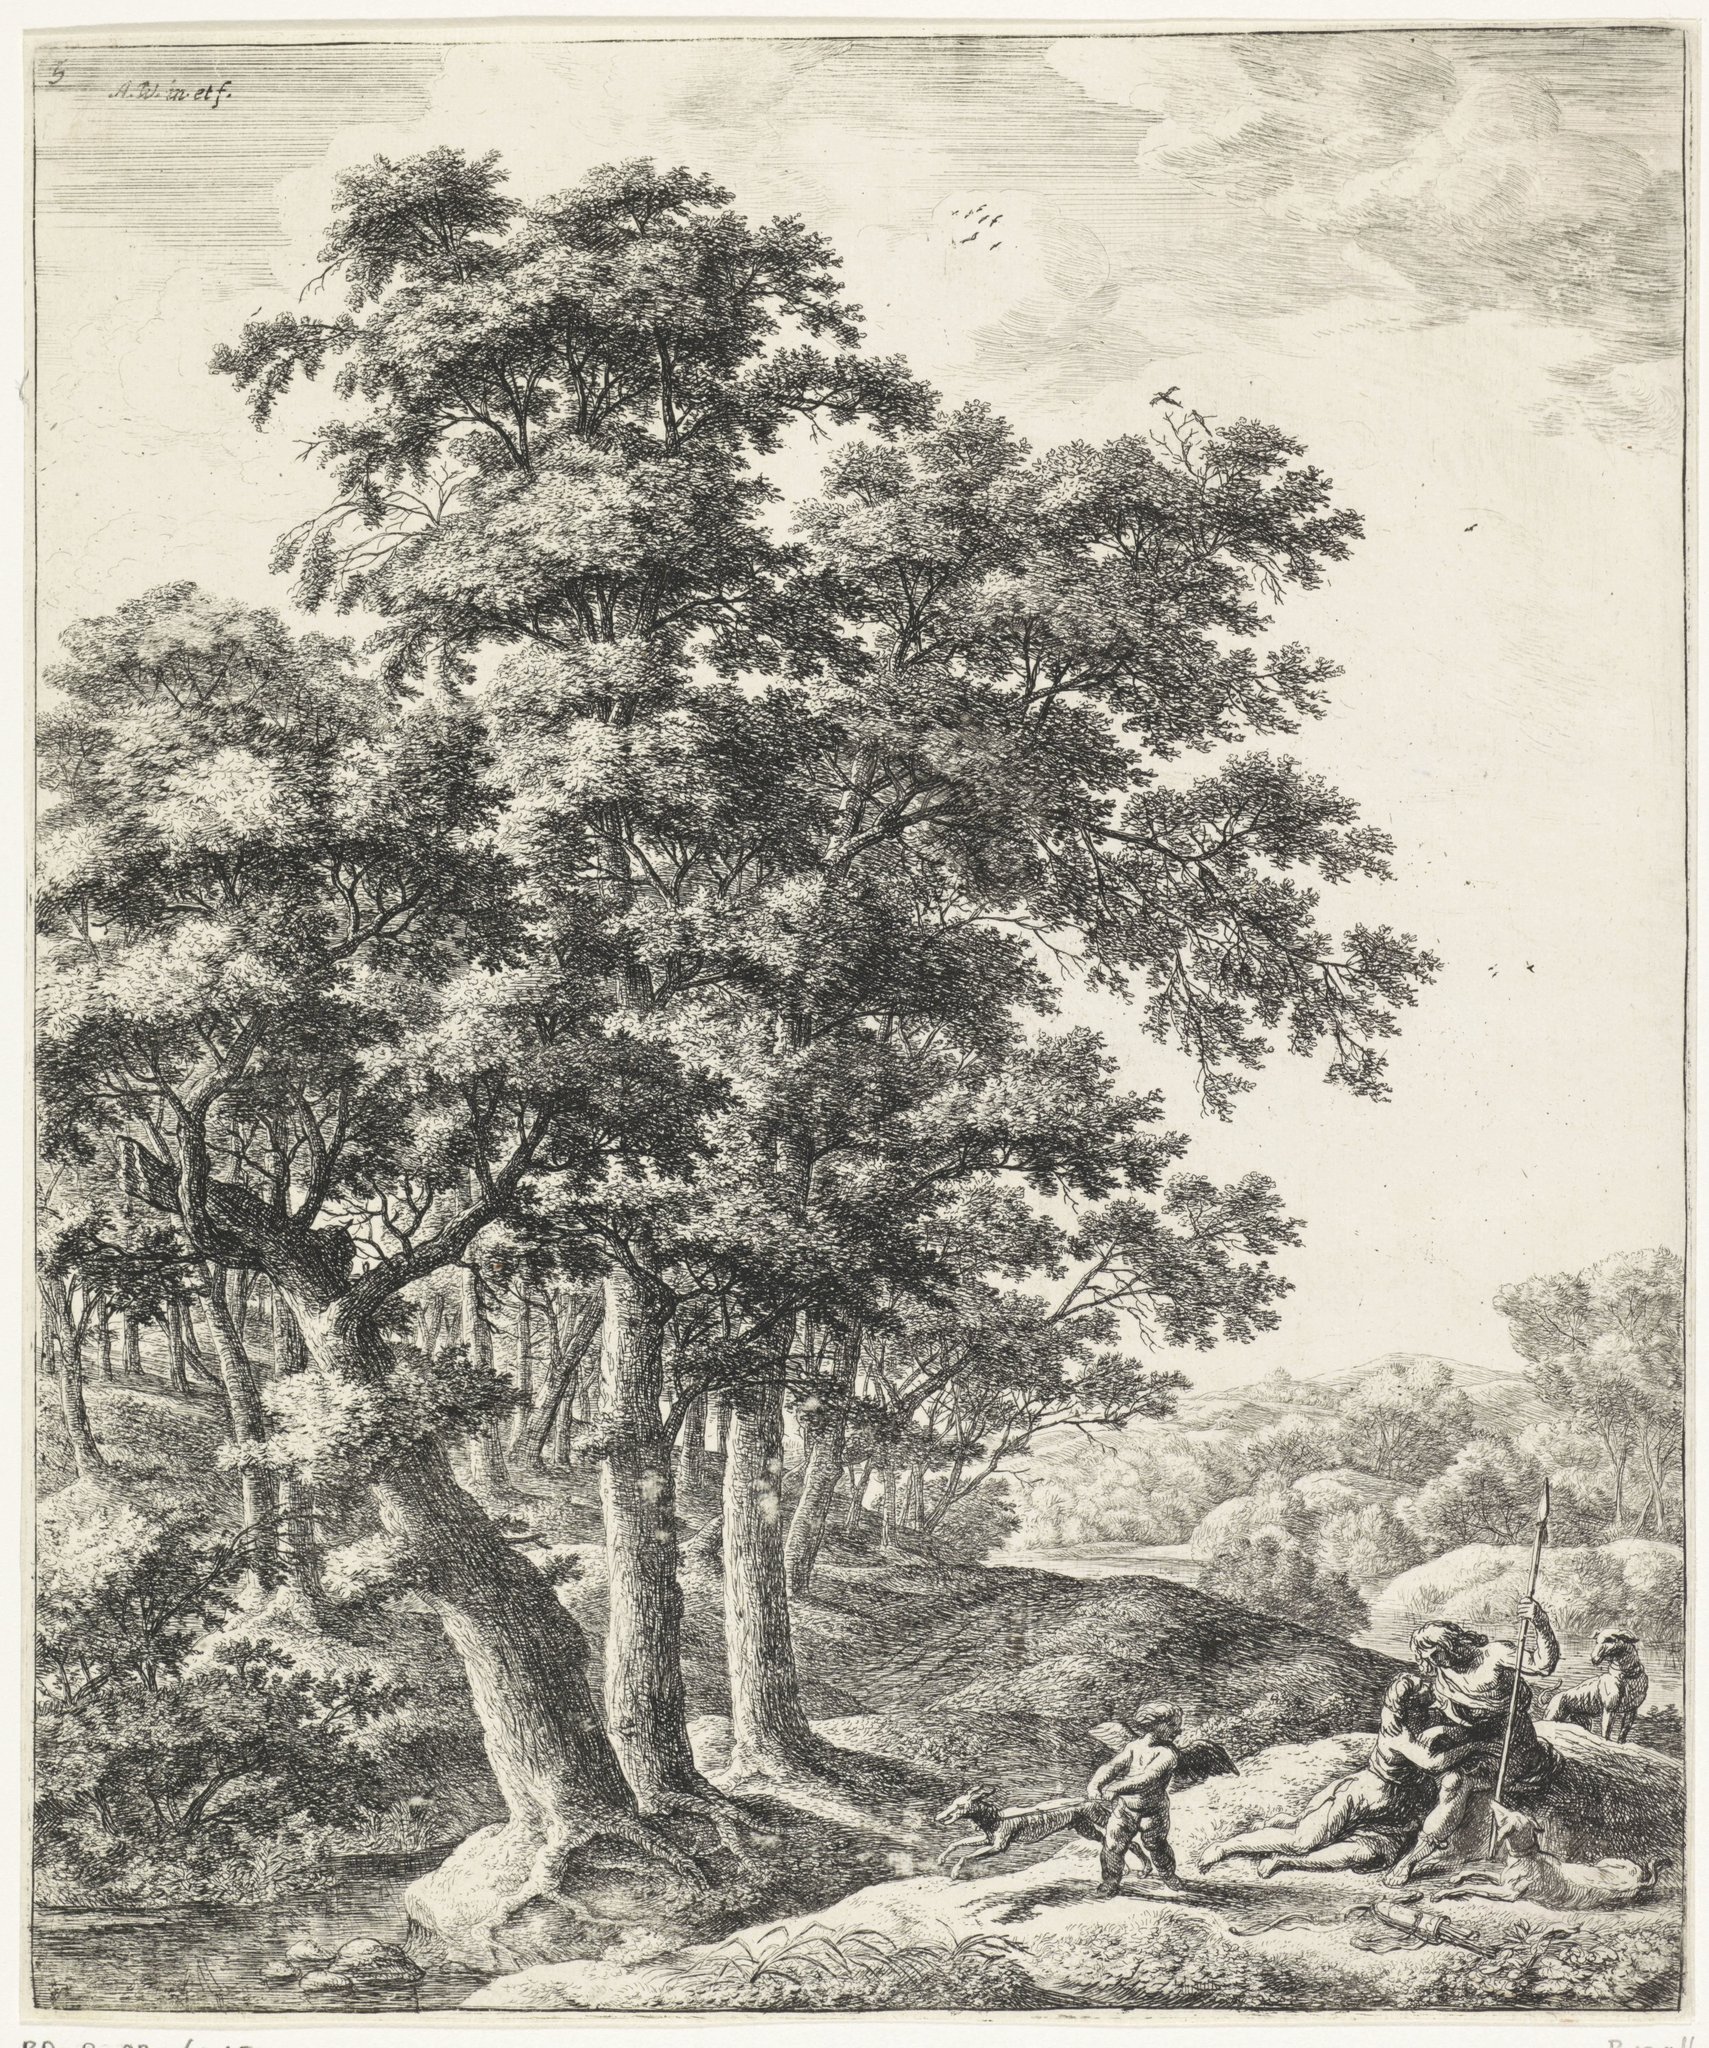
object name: print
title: Venus and Adonis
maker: anthonie waterloo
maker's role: draughtsman, painter, print maker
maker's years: 1609-1690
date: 1630-1663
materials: paper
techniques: etching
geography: amsterdam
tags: forest, wood, venus and adonis as lovers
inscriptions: collector's mark: Lugt 240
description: In een glooiend, bosrijk landschap zit Adonis op een kleine heuvel. Hij omarmt Venus, die tegen hem aanleunt. Voor en achter hem is een hond weergegeven. Op de grond ligt een pijlkoker. Links houdt Cupido een derde hond aan zijn lijn vast. Linksvoor is een kleine waterpartij te zien.